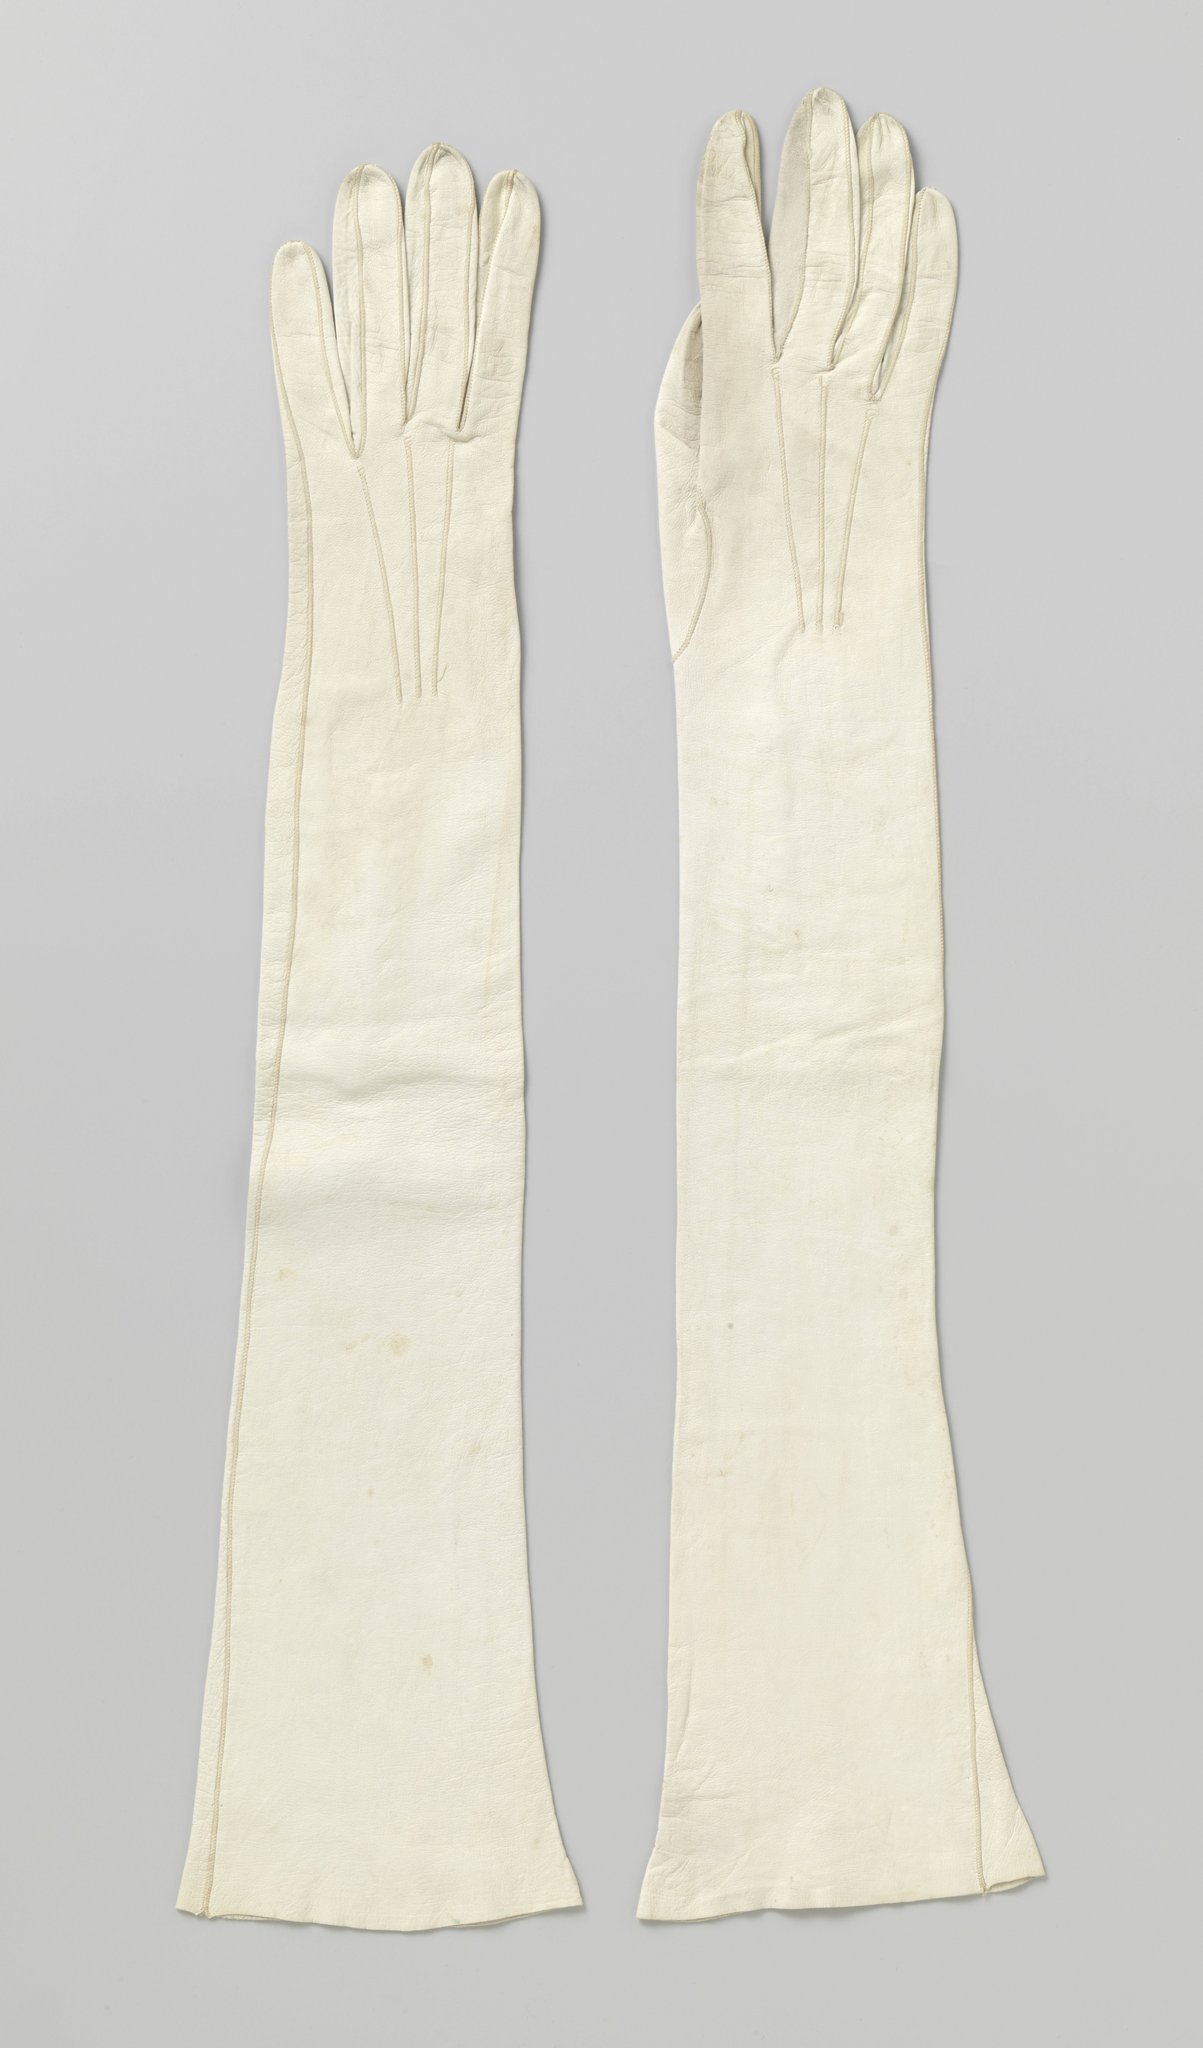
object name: glove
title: Handschoen van wit kalfsleer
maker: Anonymous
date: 1900-1925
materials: leather, cotton, mother of pearl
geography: netherlands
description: Paar lange handschoenen van wit kalfsleer, met knoopsluiting. Gemerkt met inkt: Crone J. R.3836.